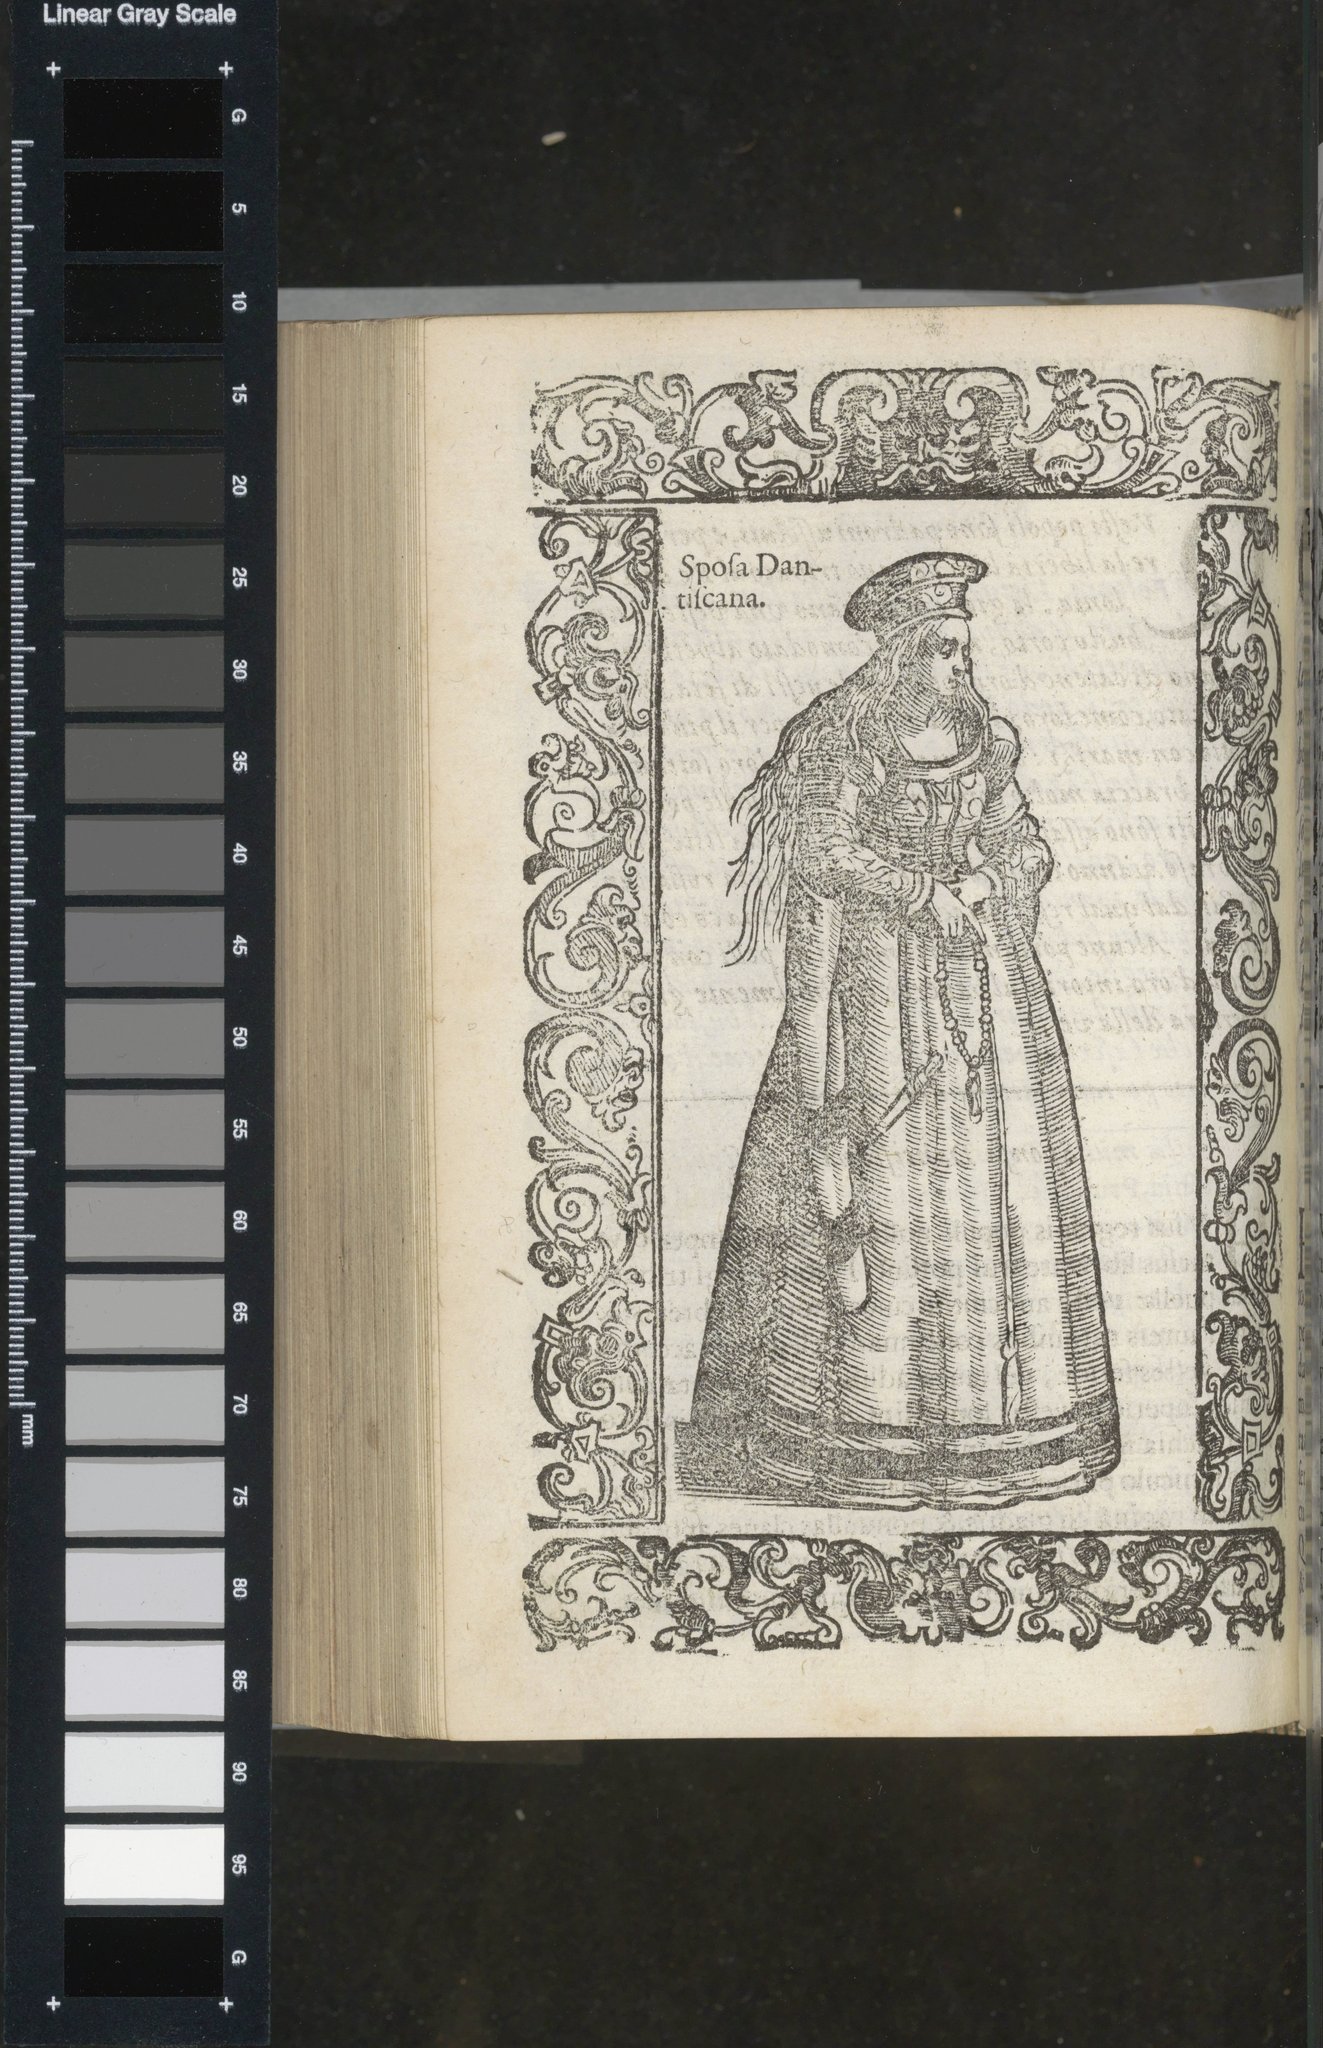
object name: costume print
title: Sposa Dantiscana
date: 1598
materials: paper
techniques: woodcut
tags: fashion plates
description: Bruid uit Danzig, gekleed volgens de traditie in Silezie.: de lange haren los over de schouders, hoofddeksel in de vorm van een ‘dogehoed’ . Overkleed met siermouwen. Rozenkrans in de hand.